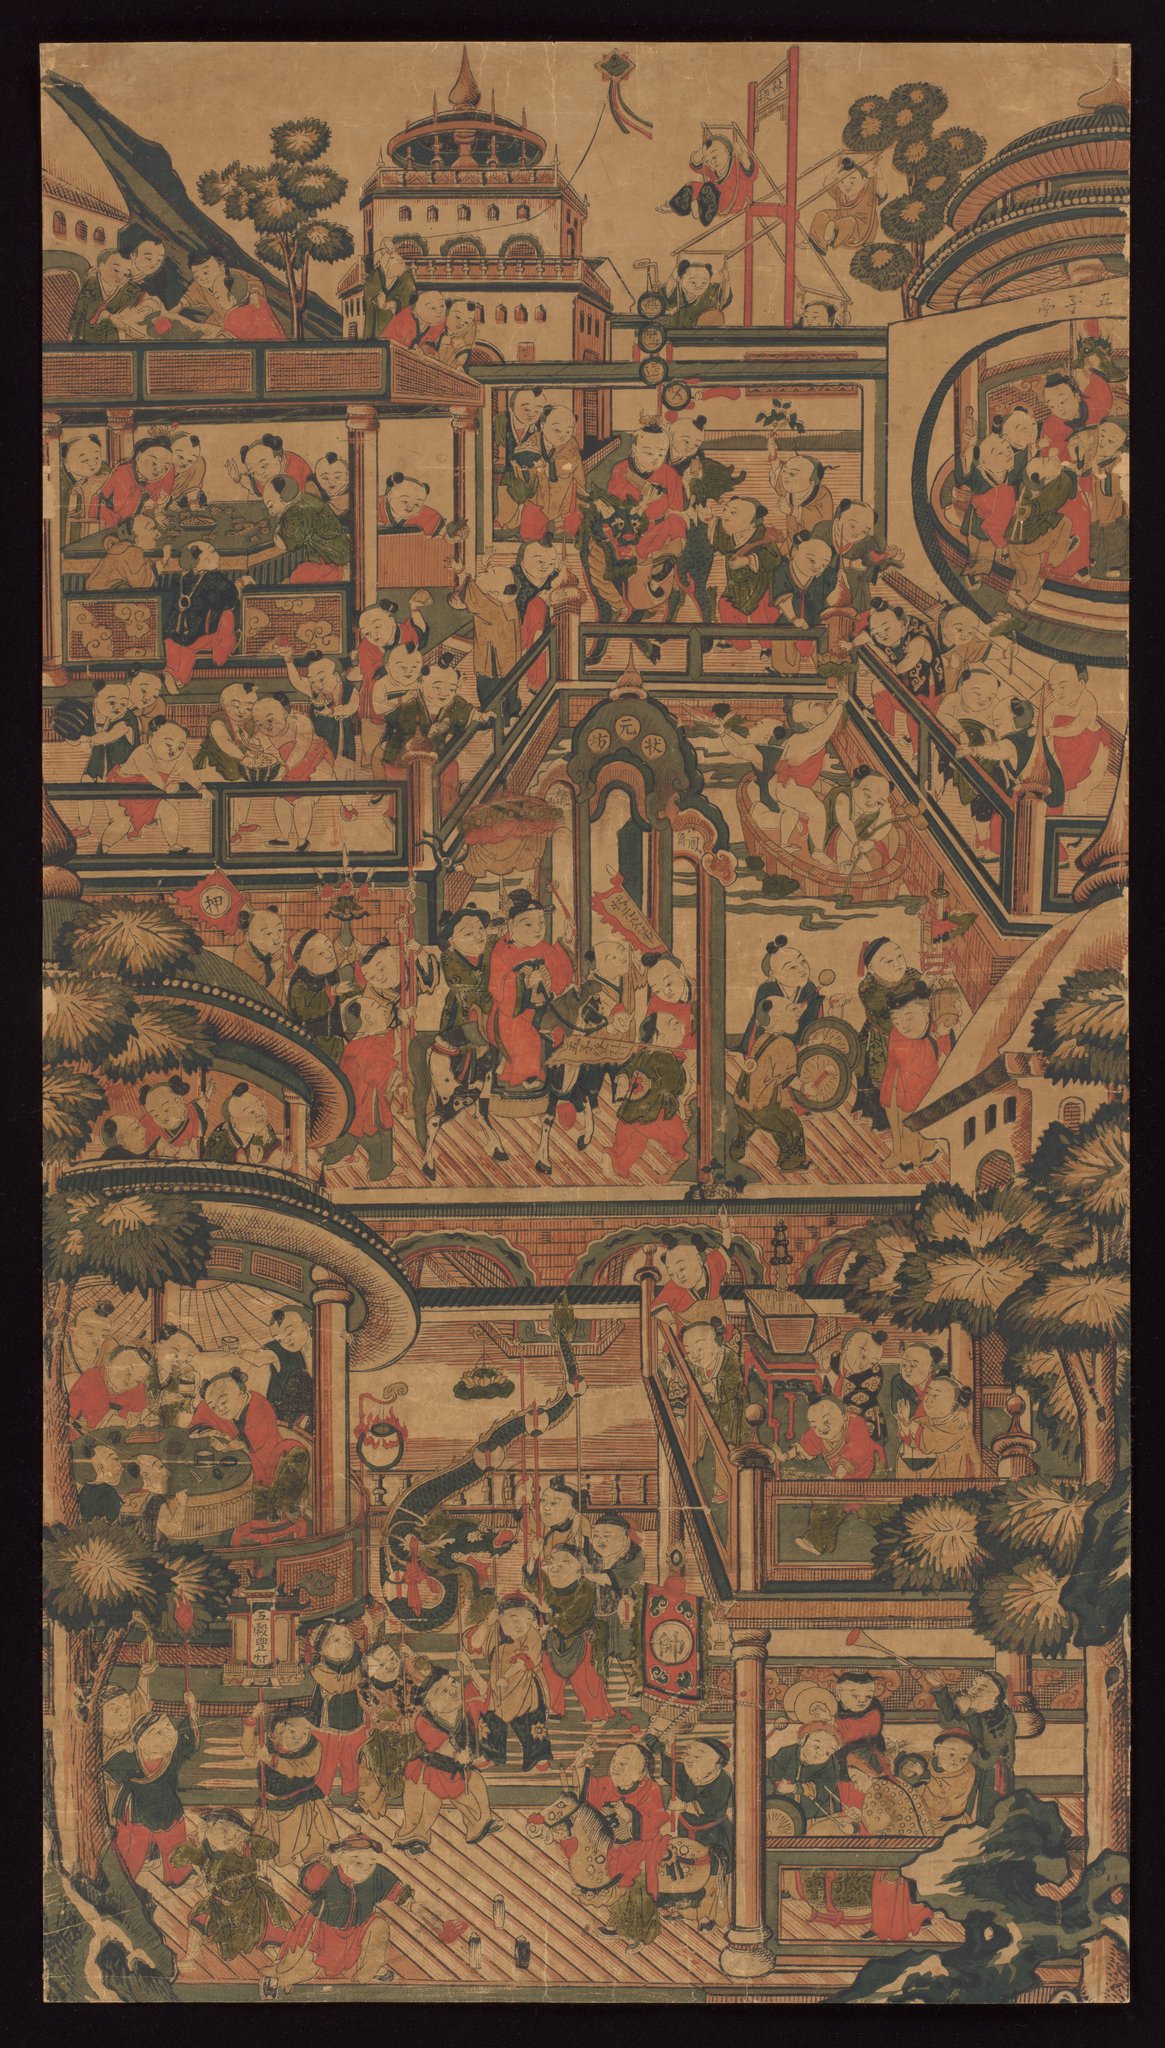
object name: print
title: One Hundred Boys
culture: chinese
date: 1736-1795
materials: ink, paper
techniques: hand coloring, woodblock print